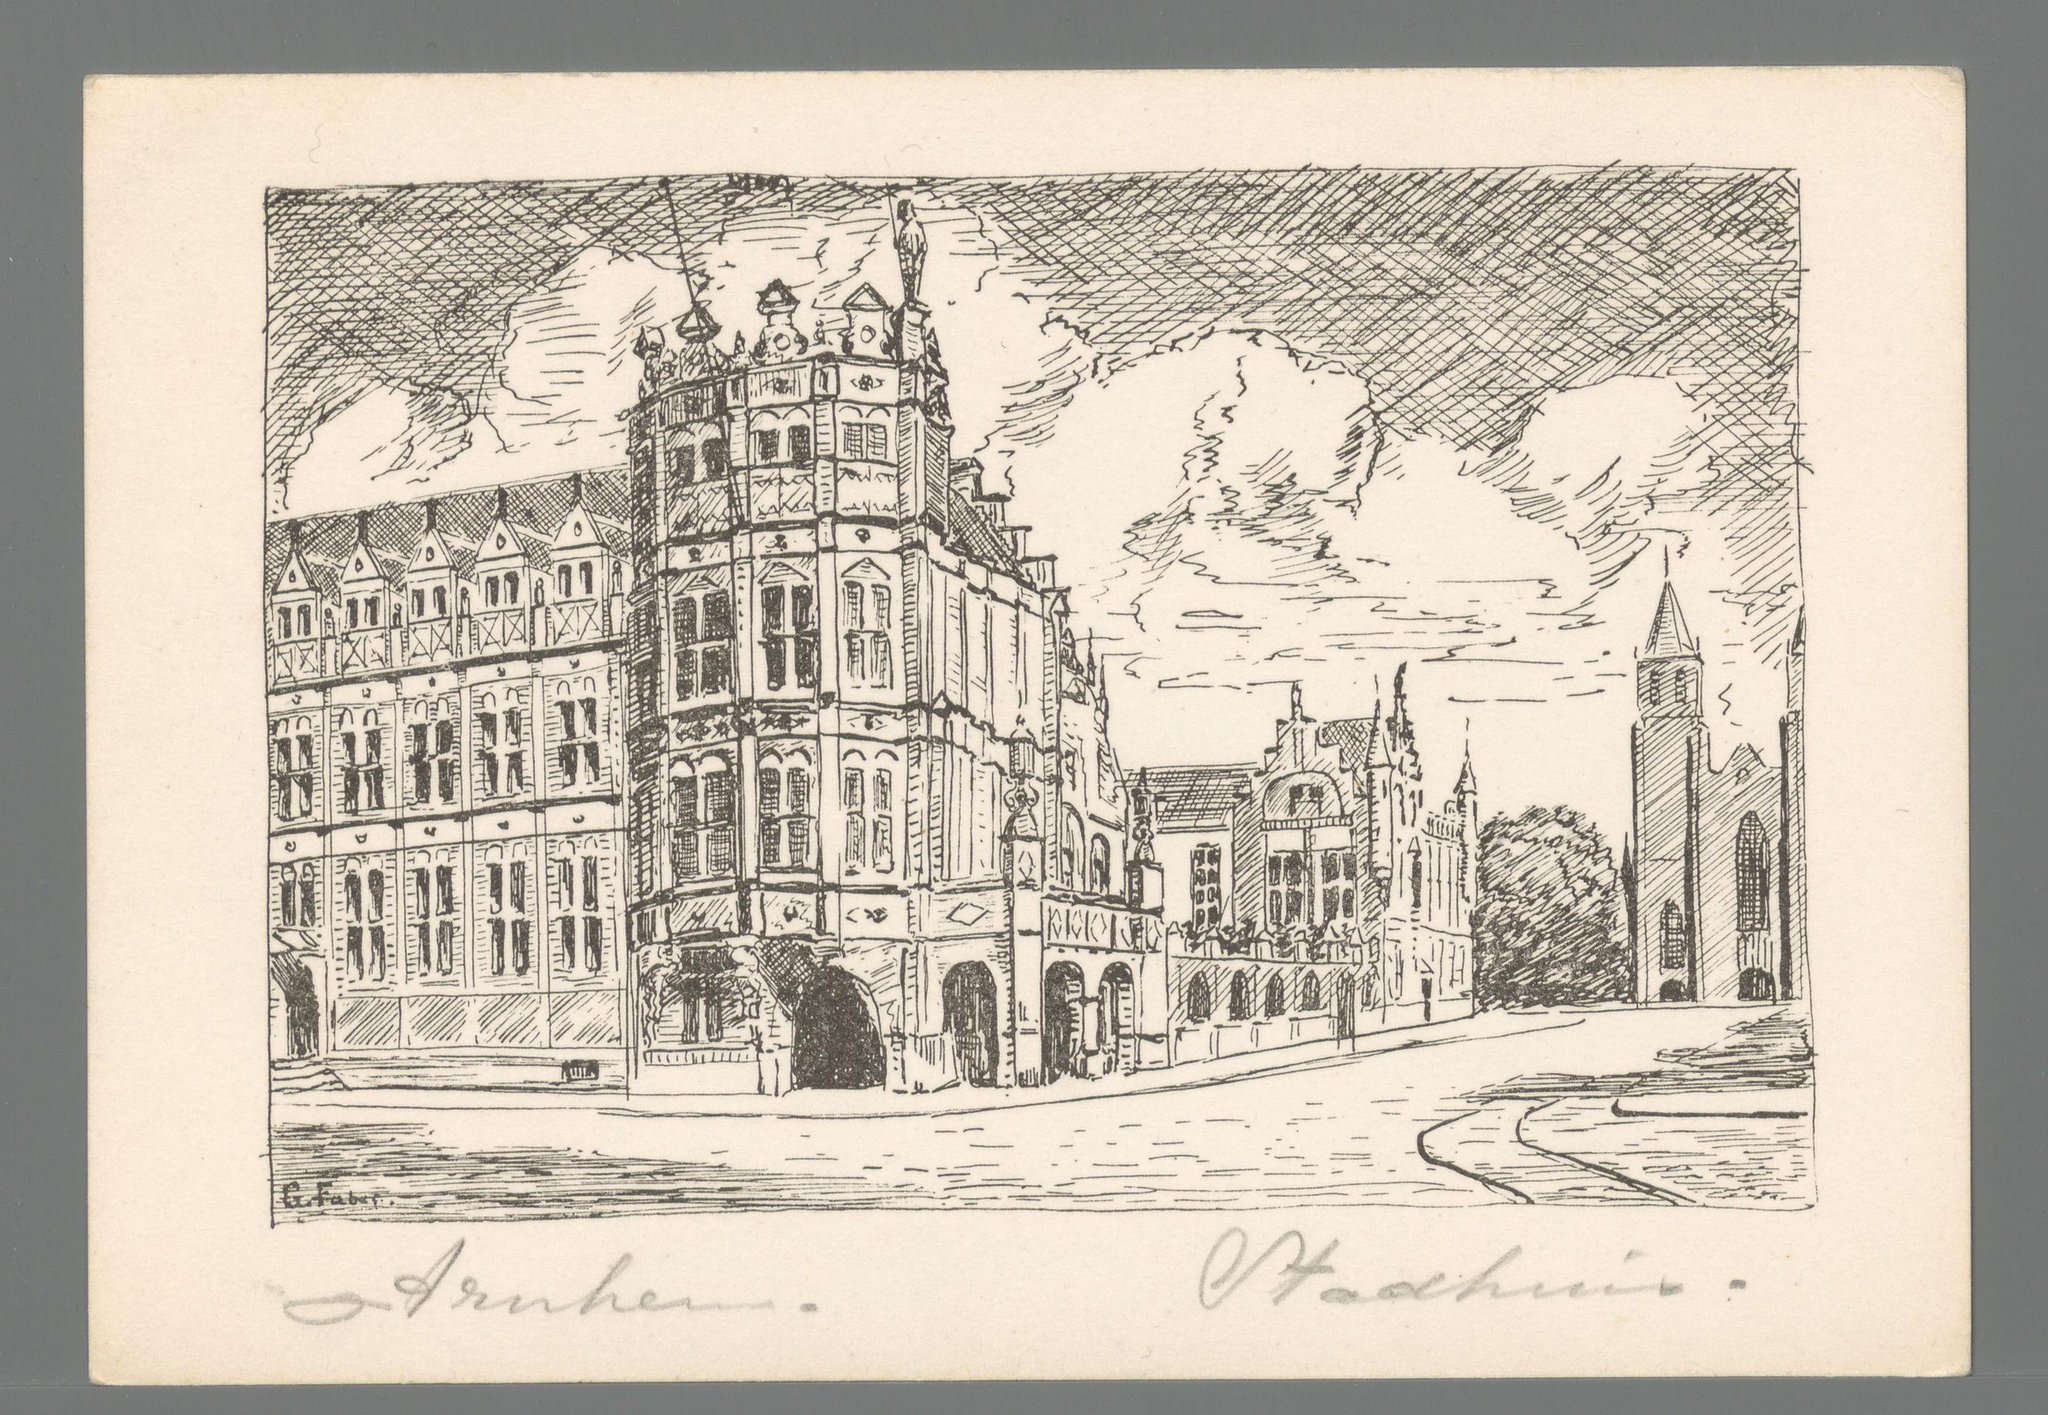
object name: reproduction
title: Arnhem. Stadhuis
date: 1935-1960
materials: cardboard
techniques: printing block, writing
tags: church (exterior), townhall, street